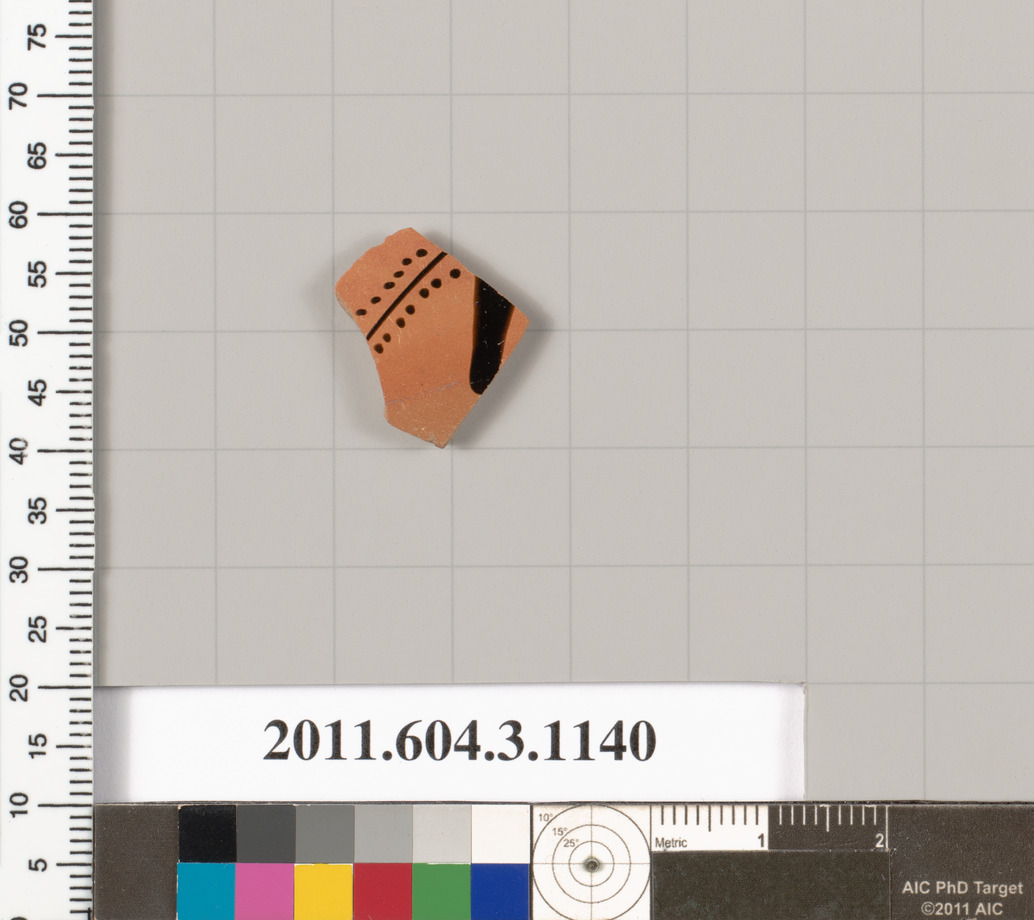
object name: mastoid or kyathos fragment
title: Terracotta fragment of a mastoid (drinking cup with narrow base) or a kyathos (cup-shaped ladle)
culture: greek, attic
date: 534-468 BCE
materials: terracotta